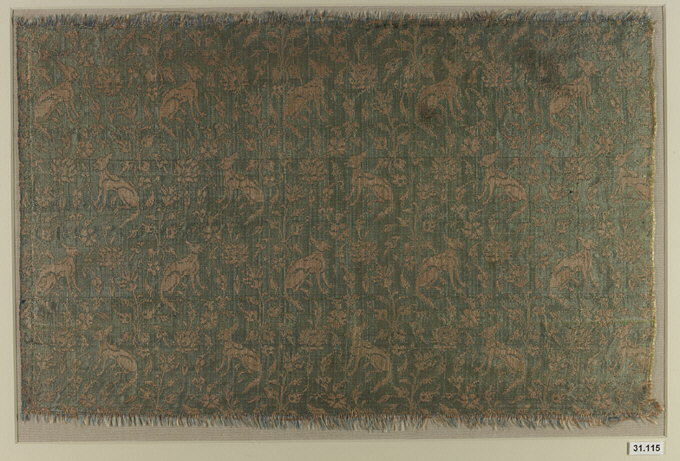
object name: textile fragment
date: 1501-1600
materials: textile, silk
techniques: weave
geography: iran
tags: foxes,roses